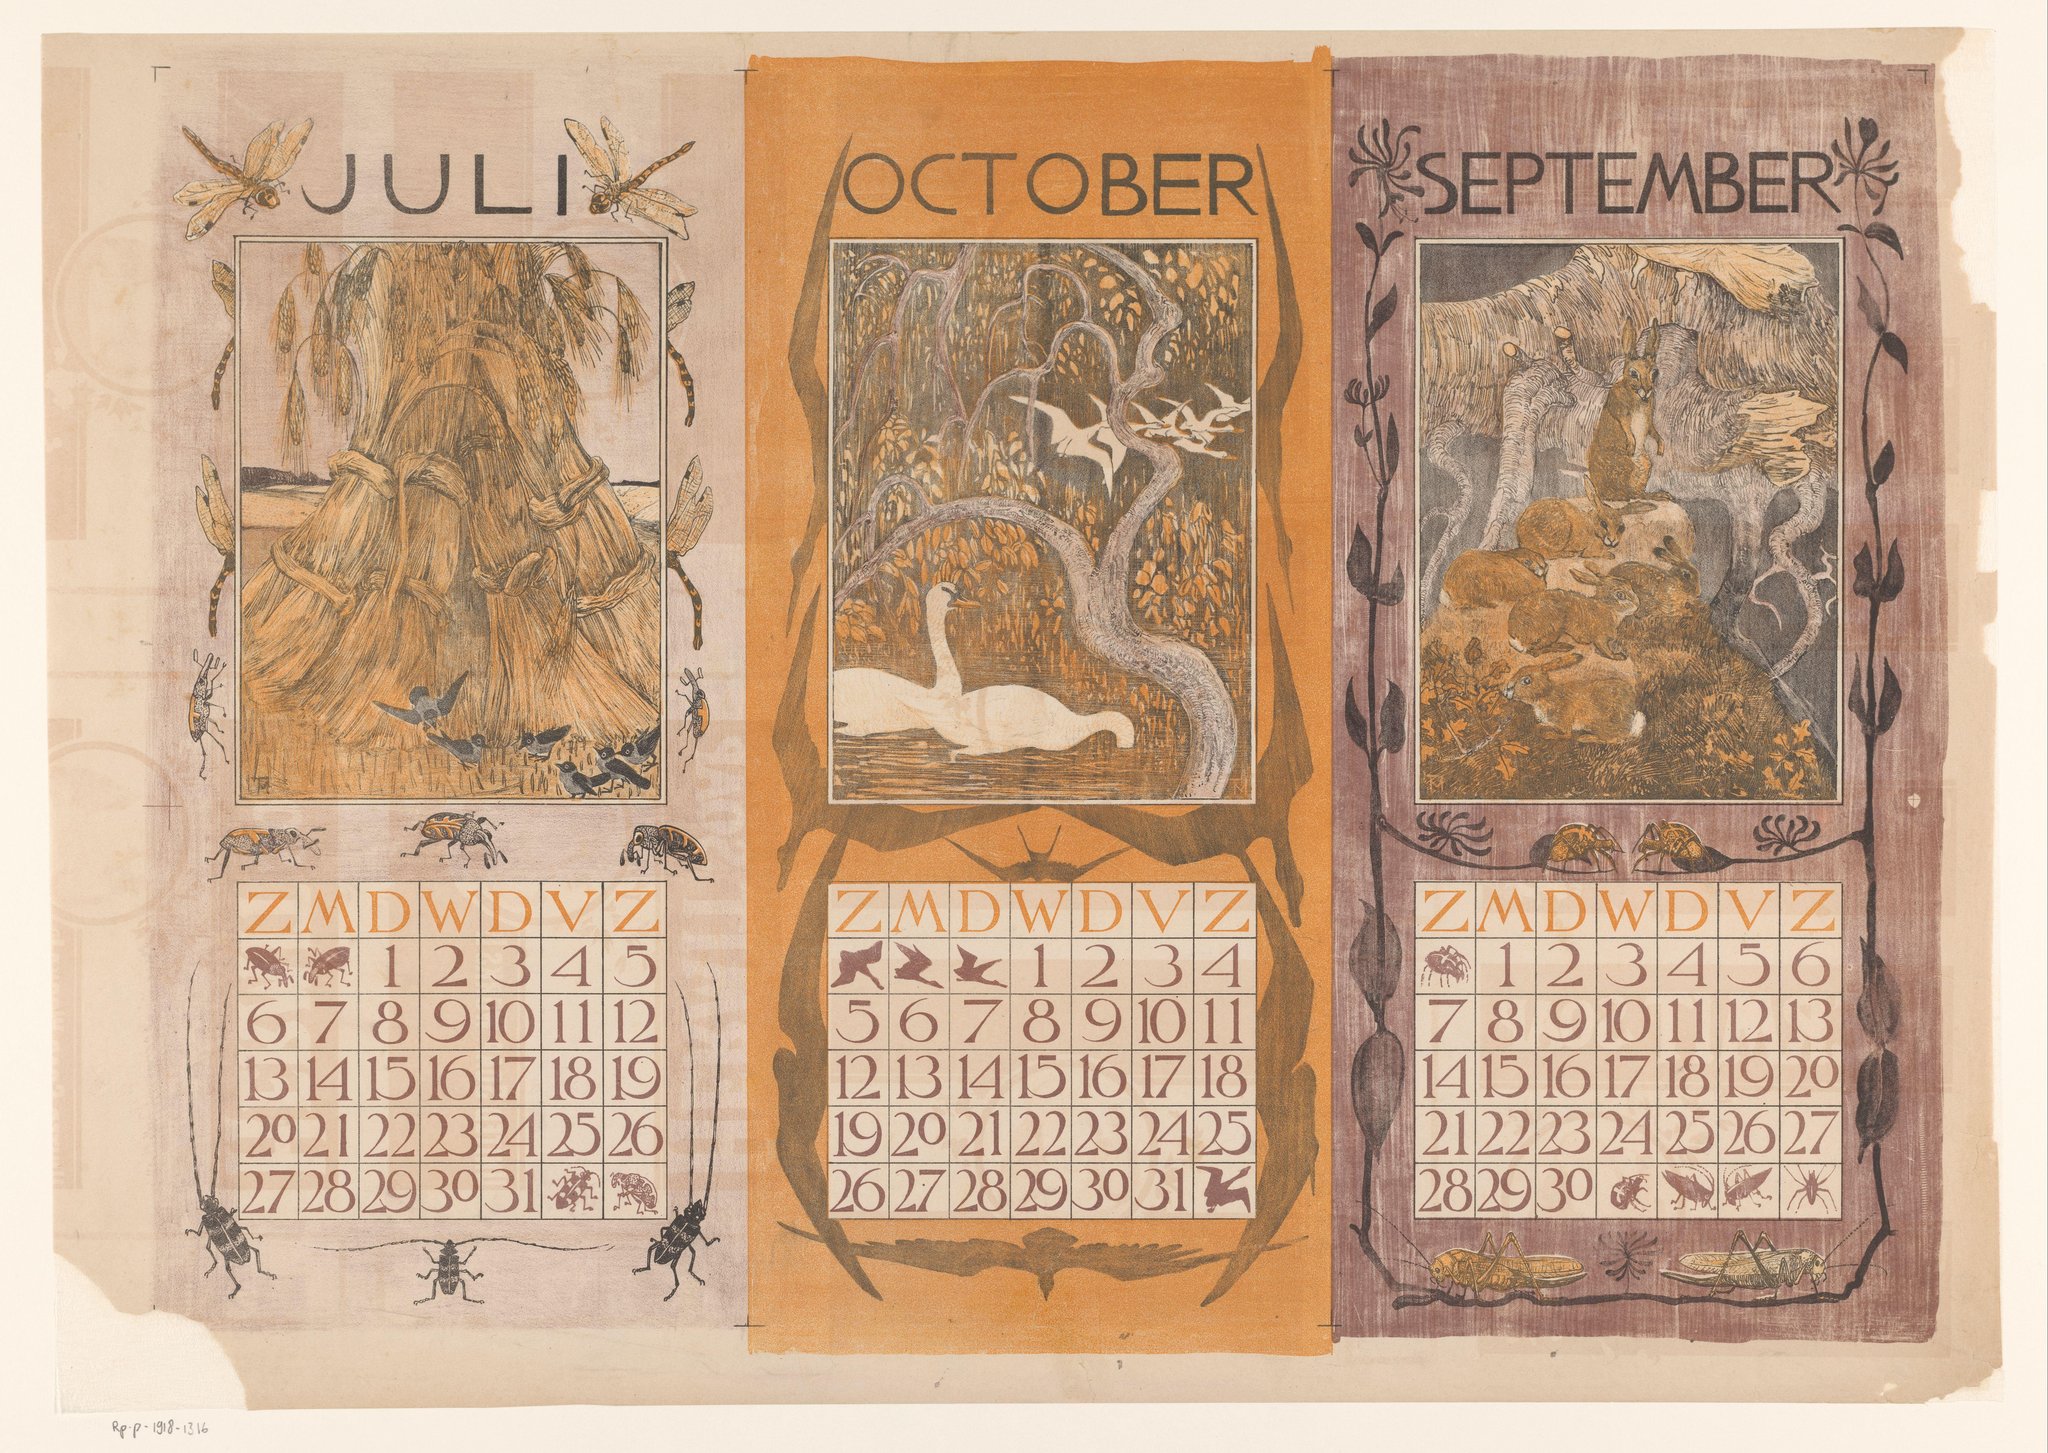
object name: calendar leaf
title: Kalenderbladen van juli, oktober en september, met korenschoven, zwanen en konijnen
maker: theo van hoytema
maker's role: draughtsman, painter, print maker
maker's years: 1863-1917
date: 1901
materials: paper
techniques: lithograph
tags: plants and herbs: wheat, calendar, almanac, water-birds: swan, rodents: rabbit